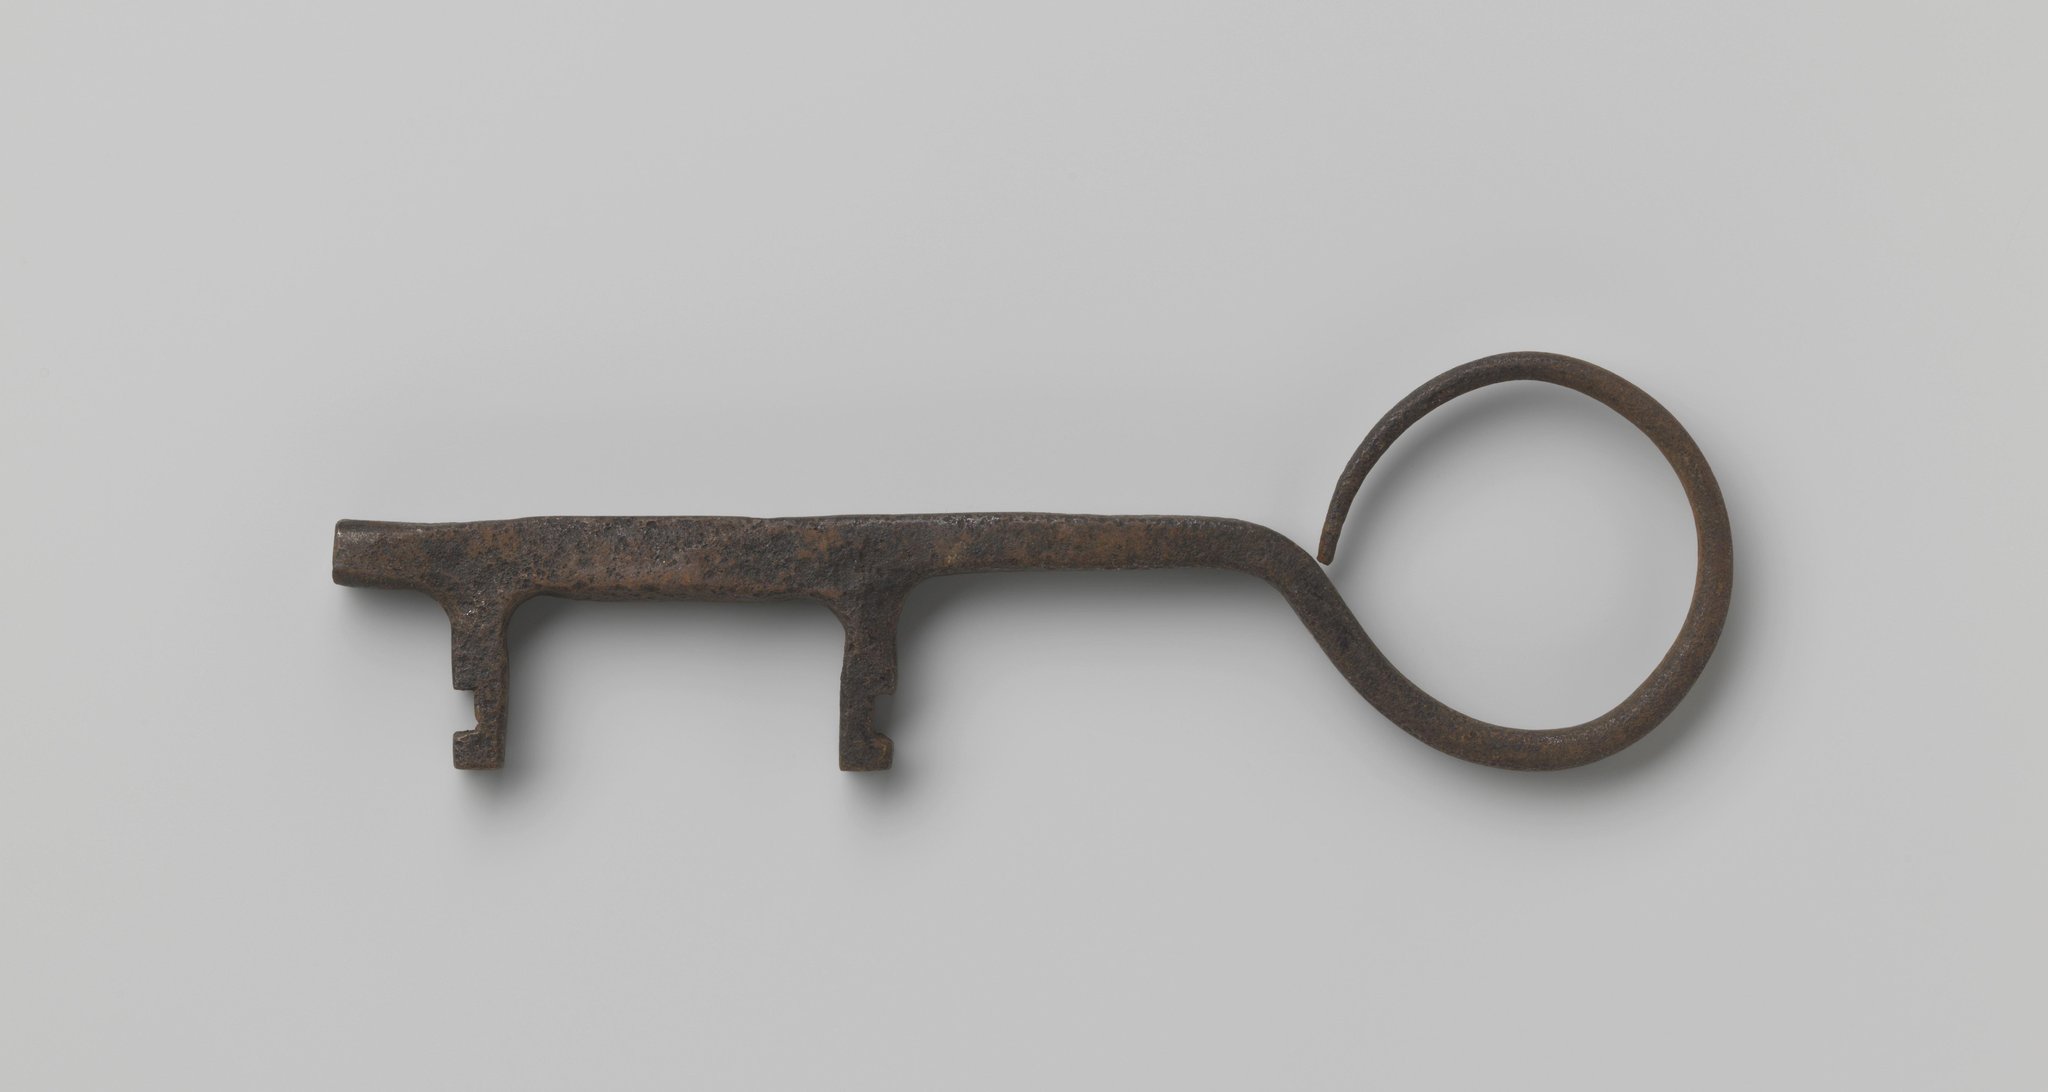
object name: key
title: Sleutel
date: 1700-1900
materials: iron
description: Sleutel met vierkante steel, aan het einde spits toelopend en in een oog ombuigend. De baard is tweeledig.